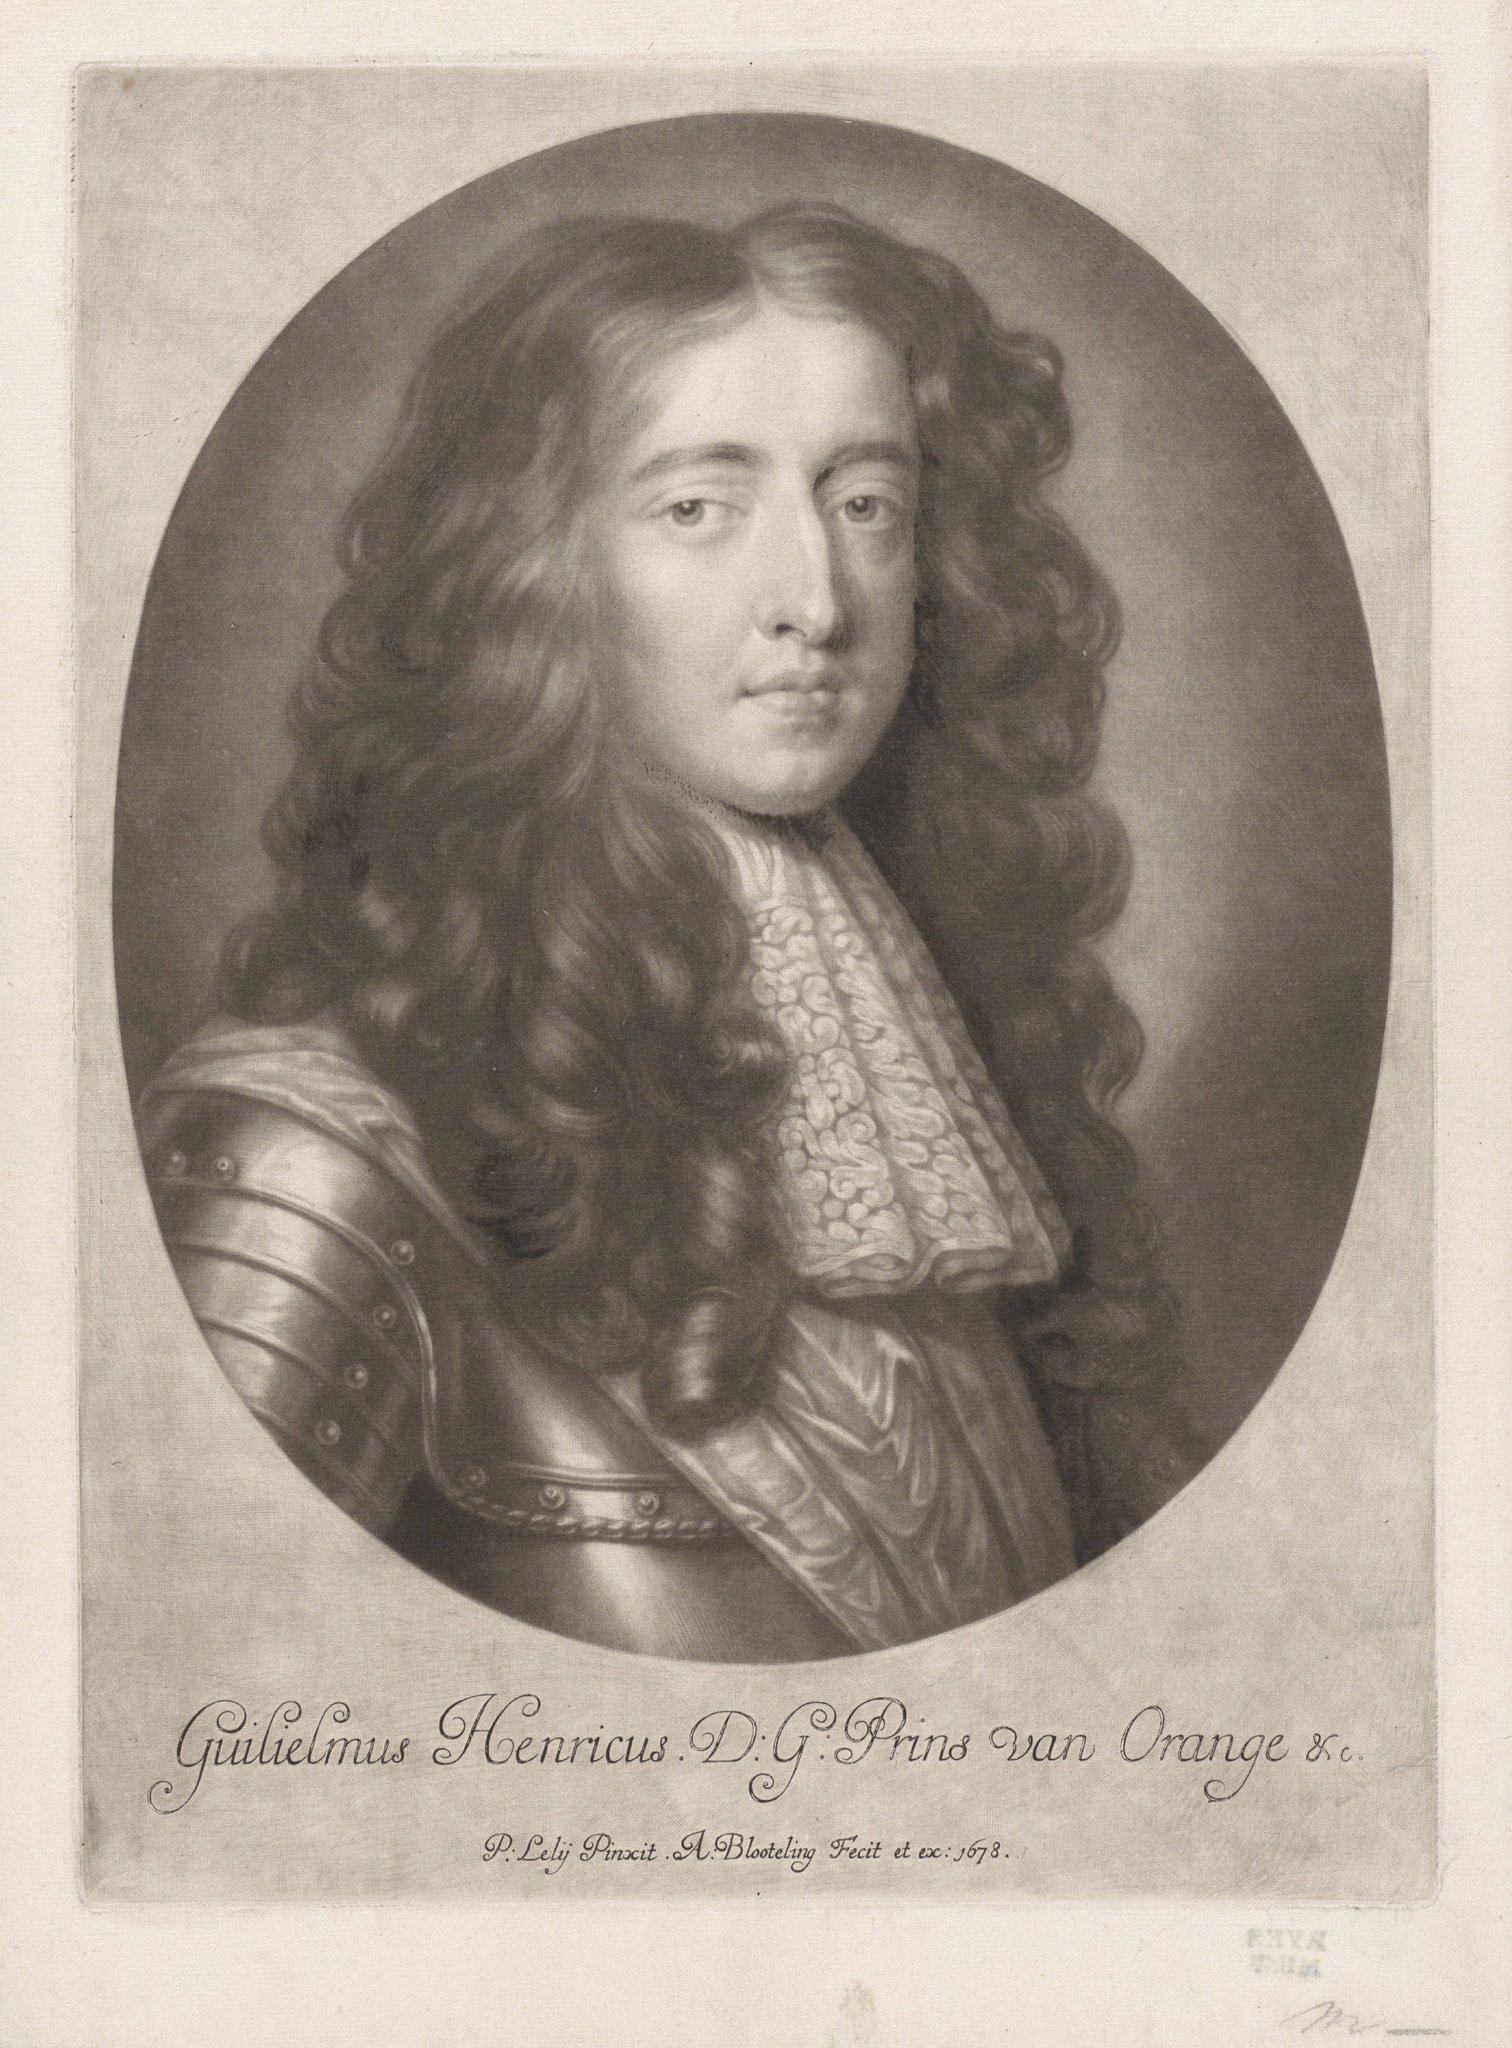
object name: print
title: Portret van Willem III, prins van Oranje-Nassau, koning van Engeland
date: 1678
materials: paper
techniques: engraving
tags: the hague, william iii (prince of orange and king of england, scotland, and ireland), harness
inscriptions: collector's mark: Lugt 963, collector's mark: Lugt 2165, collector's mark: Lugt 2228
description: Portret van Willem III, prins van Oranje-Nassau en sinds 1689 koning van Engeland. Hij draagt een harnas met kraag van kant.